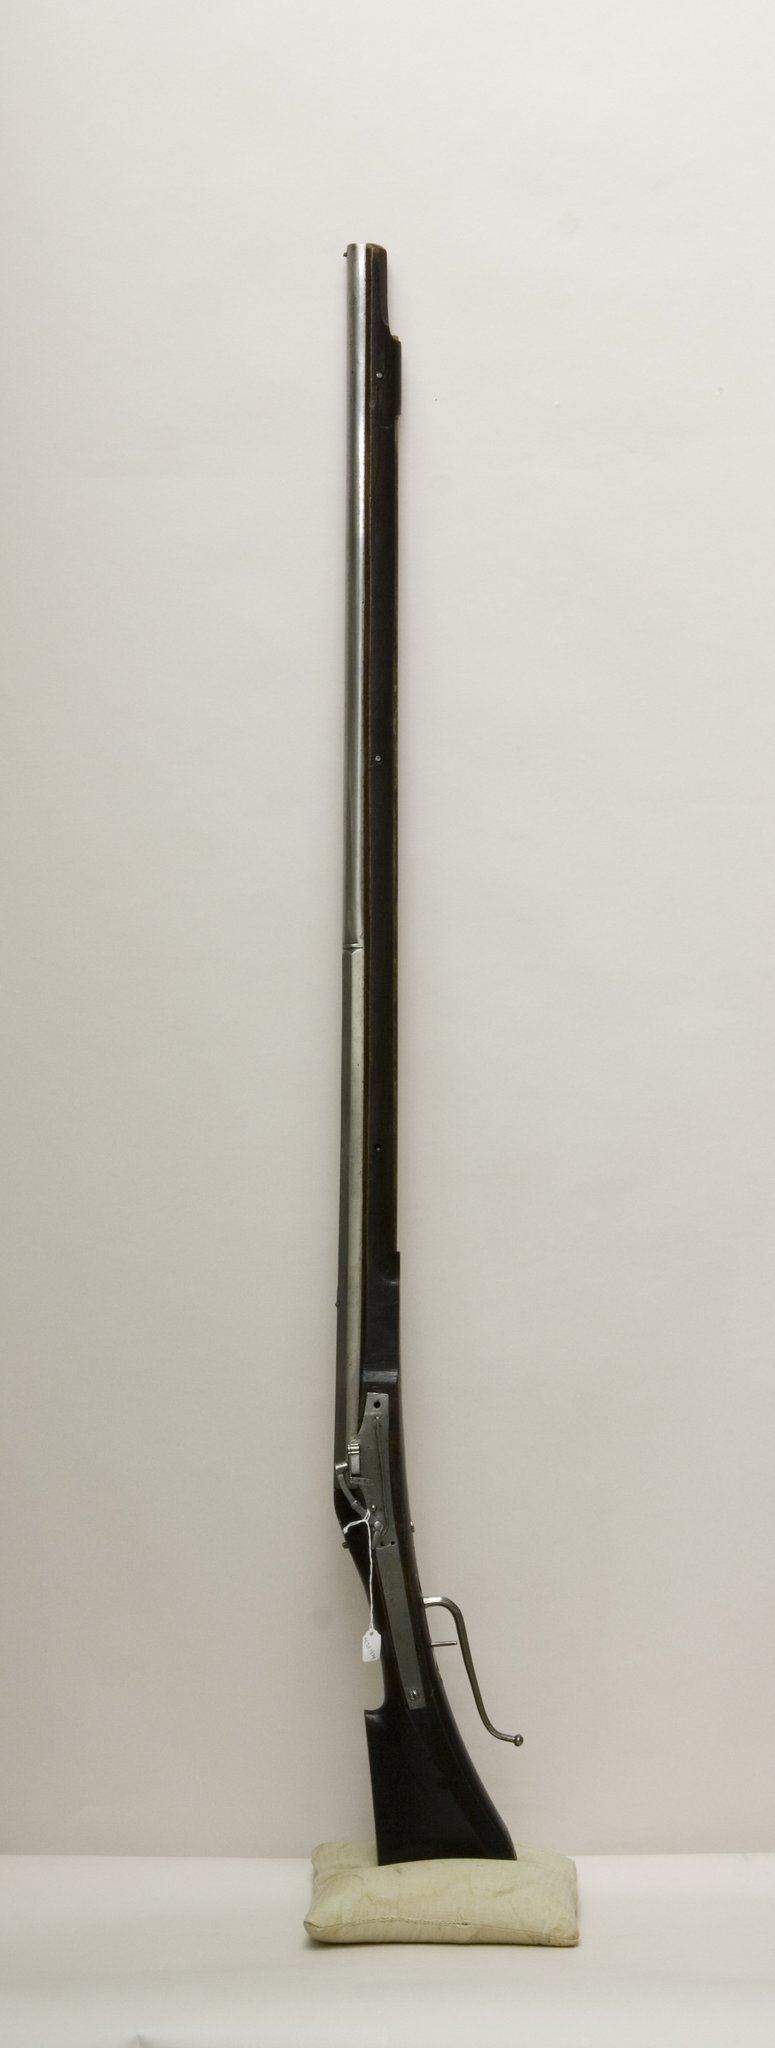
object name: matchlock gun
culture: german or austrian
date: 1567-1633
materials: steel, wood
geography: germany